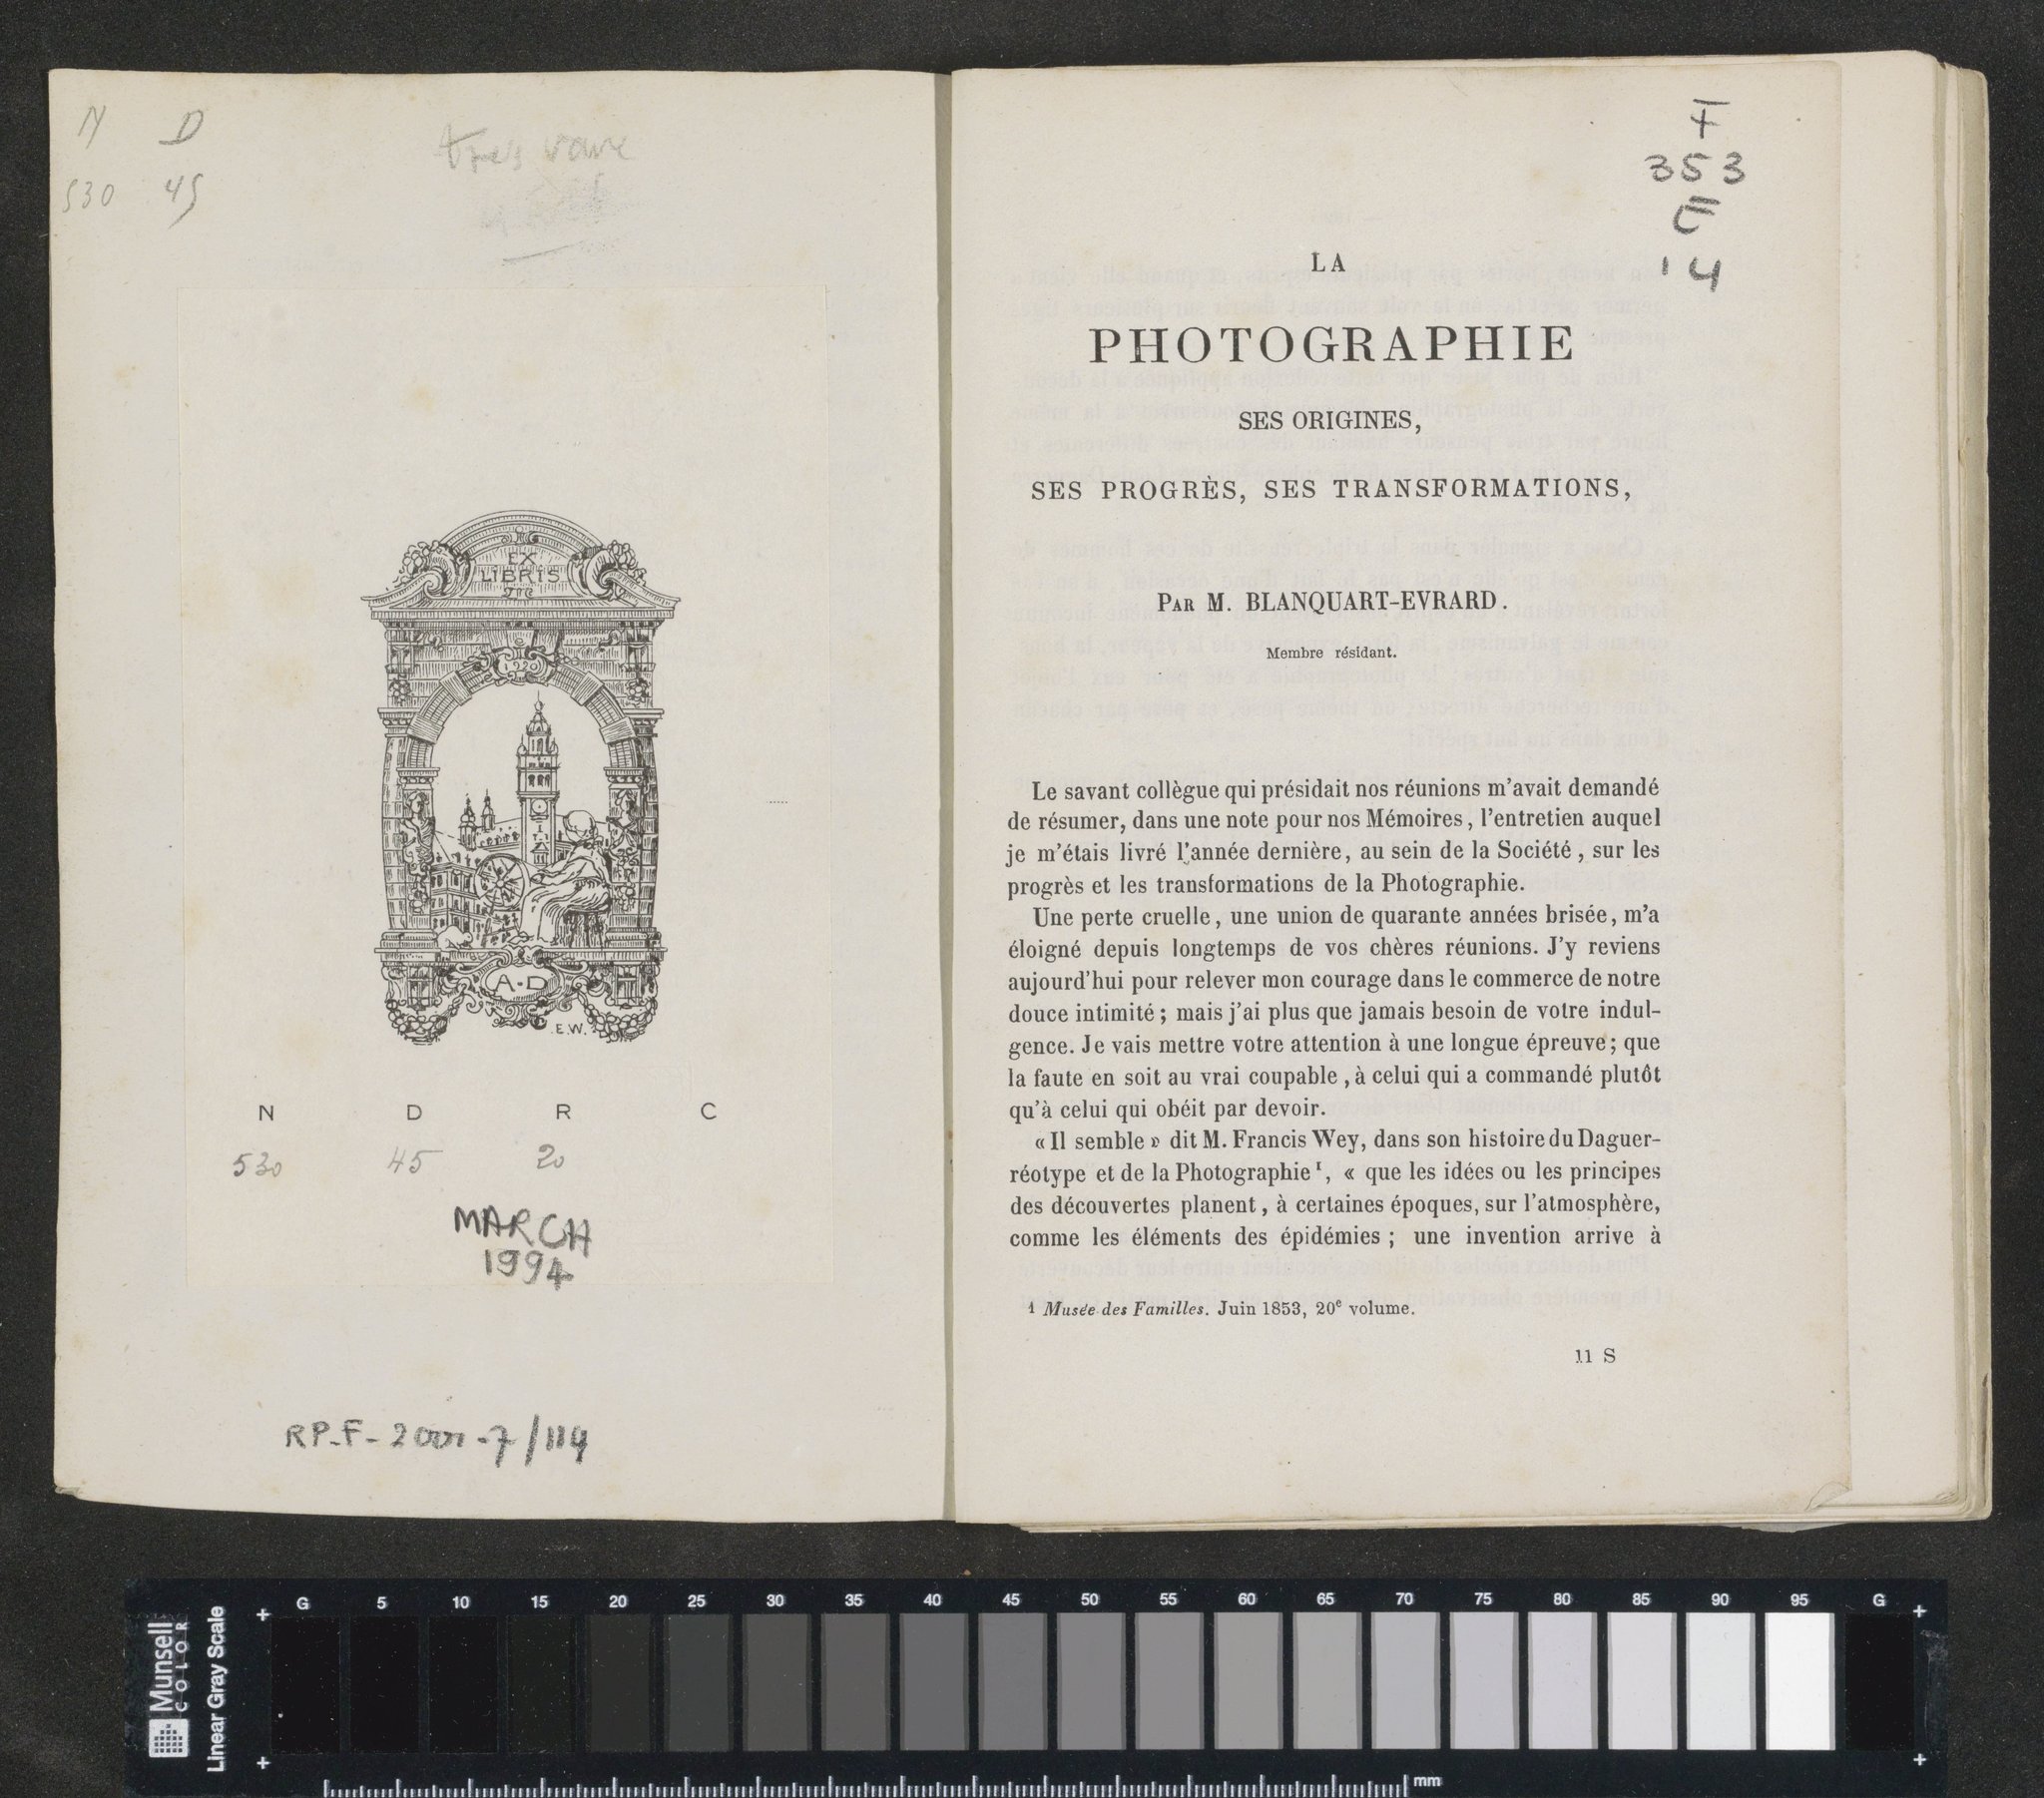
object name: book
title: La photographie ses origines, ses progrès, ses transformations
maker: louis-désiré blanquart-evrard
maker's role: printer, publisher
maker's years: 1802-1872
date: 1869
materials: cardboard, paper, photographic support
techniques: carbon print, photograph, photoaquatint, photolithography, printing, salted paper print, woodburytype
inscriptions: inscription: ‘ex libris N D R C’